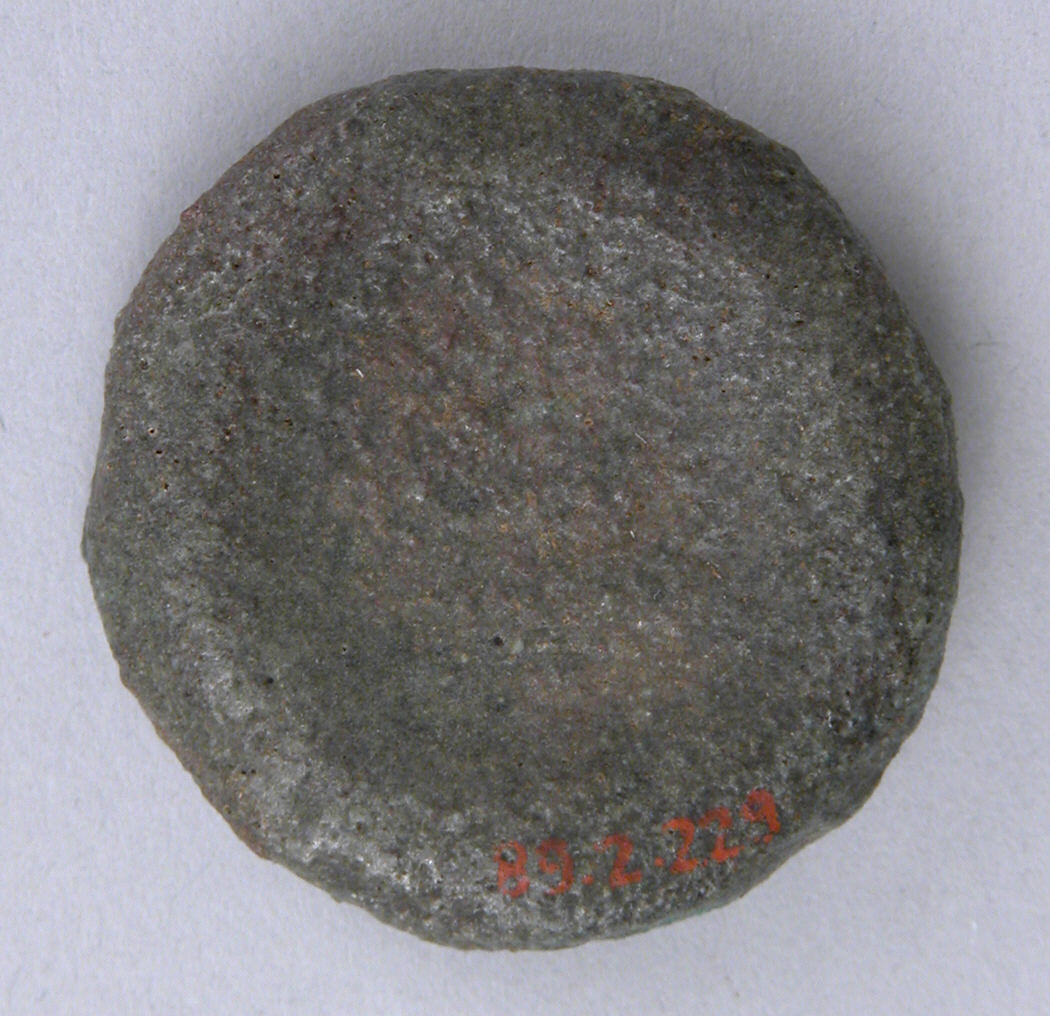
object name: coin weight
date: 901-1400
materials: glass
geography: egypt